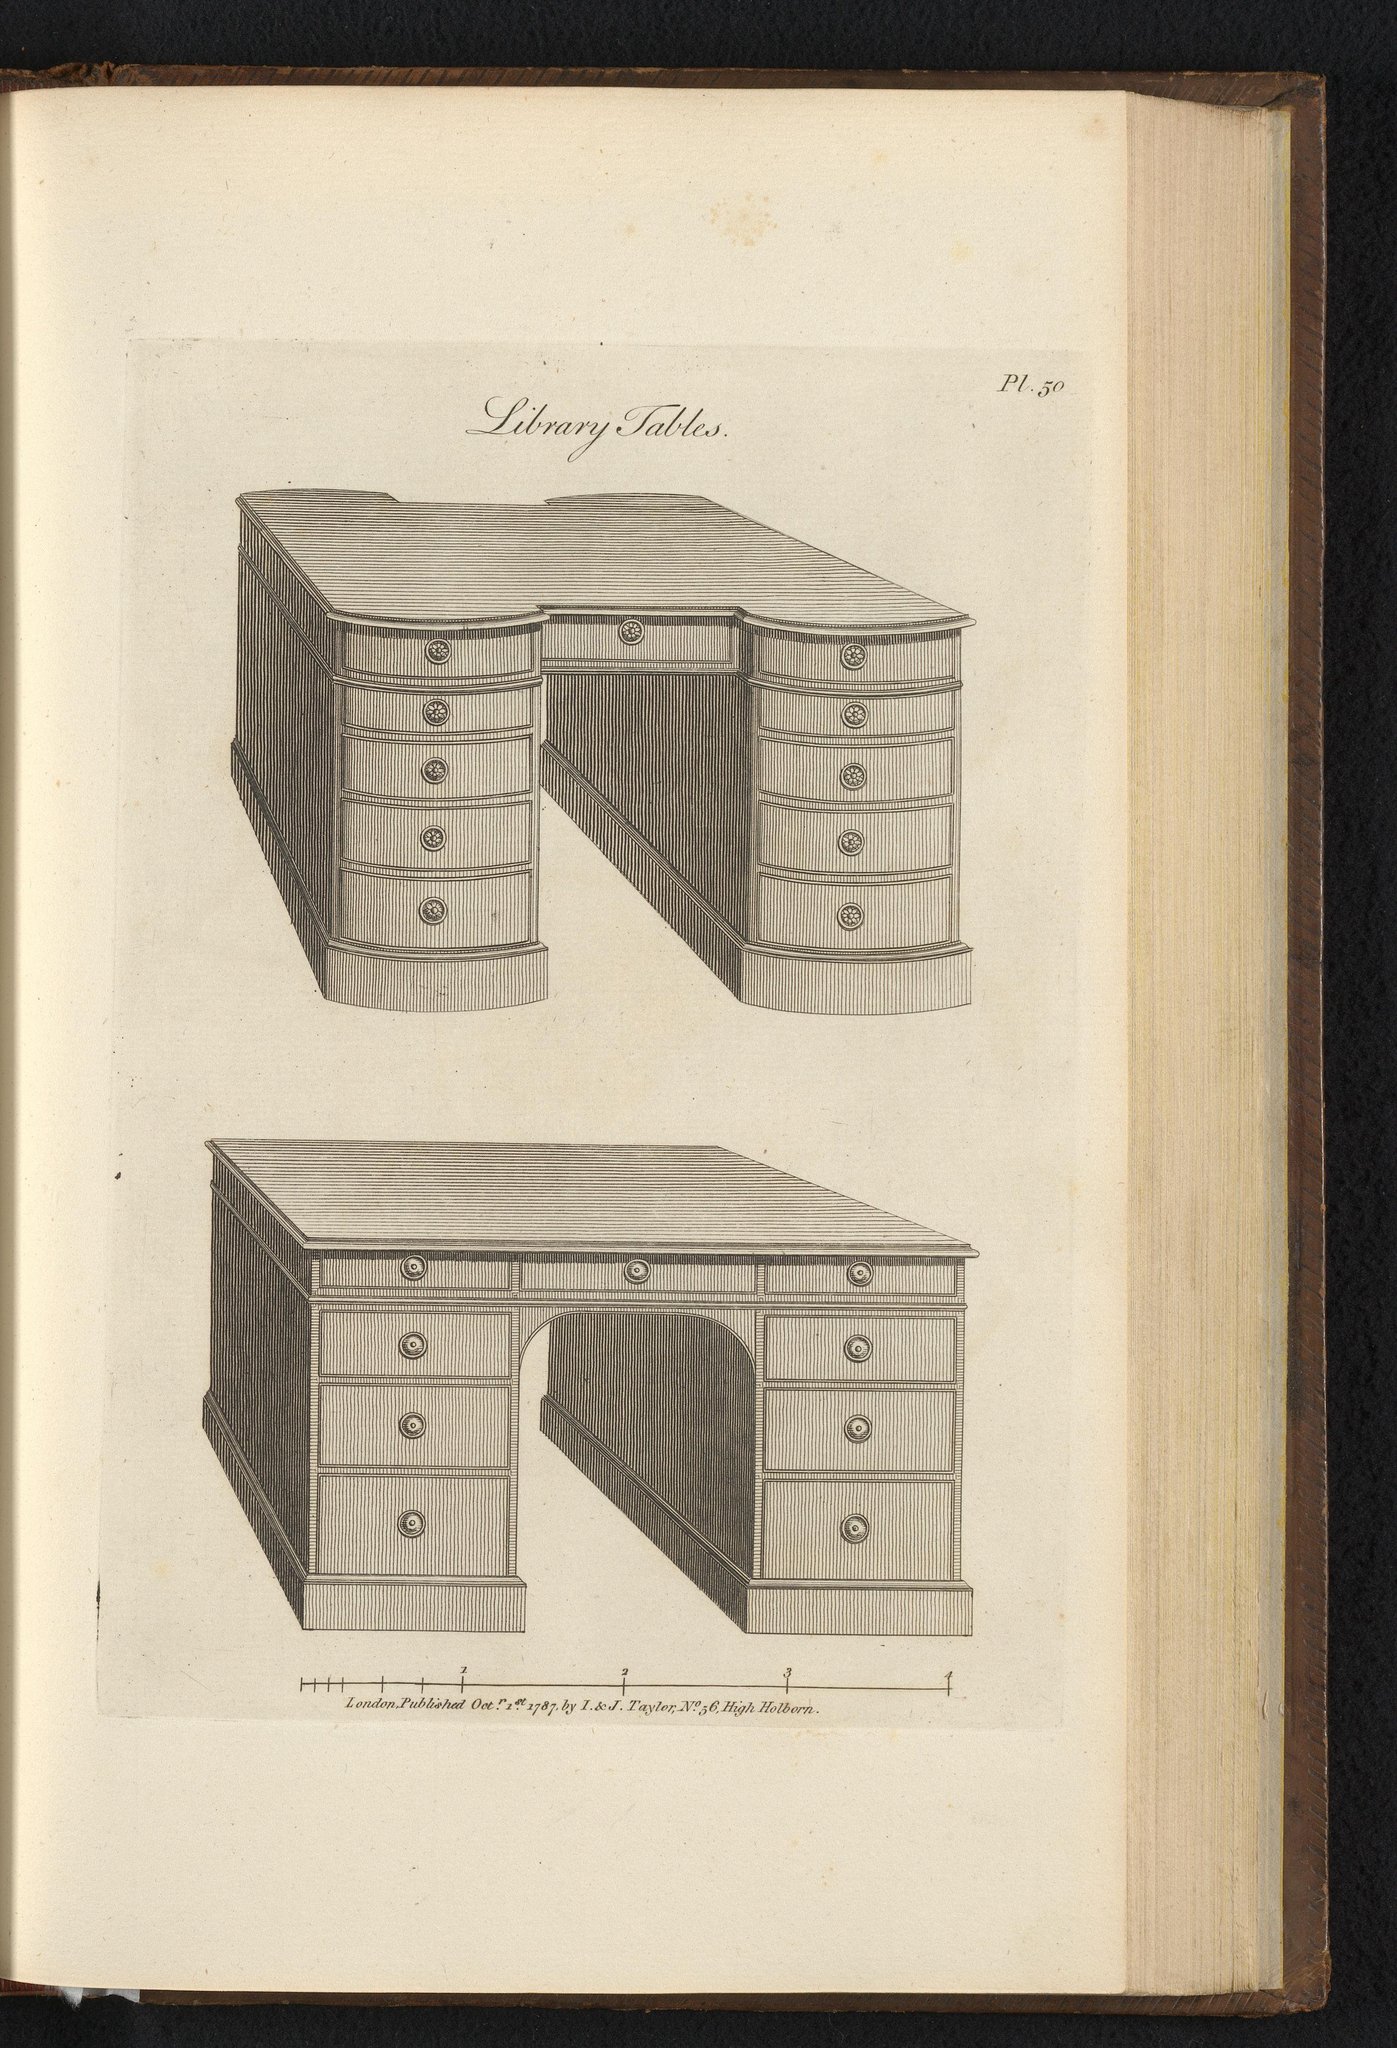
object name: print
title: Meubels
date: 1787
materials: paper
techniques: engraving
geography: holborn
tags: writing-table, writing-desk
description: Genummerd: Pl. 49. Schaalverdeling in de ondermarge. Prent maakt deel uit van een boek.